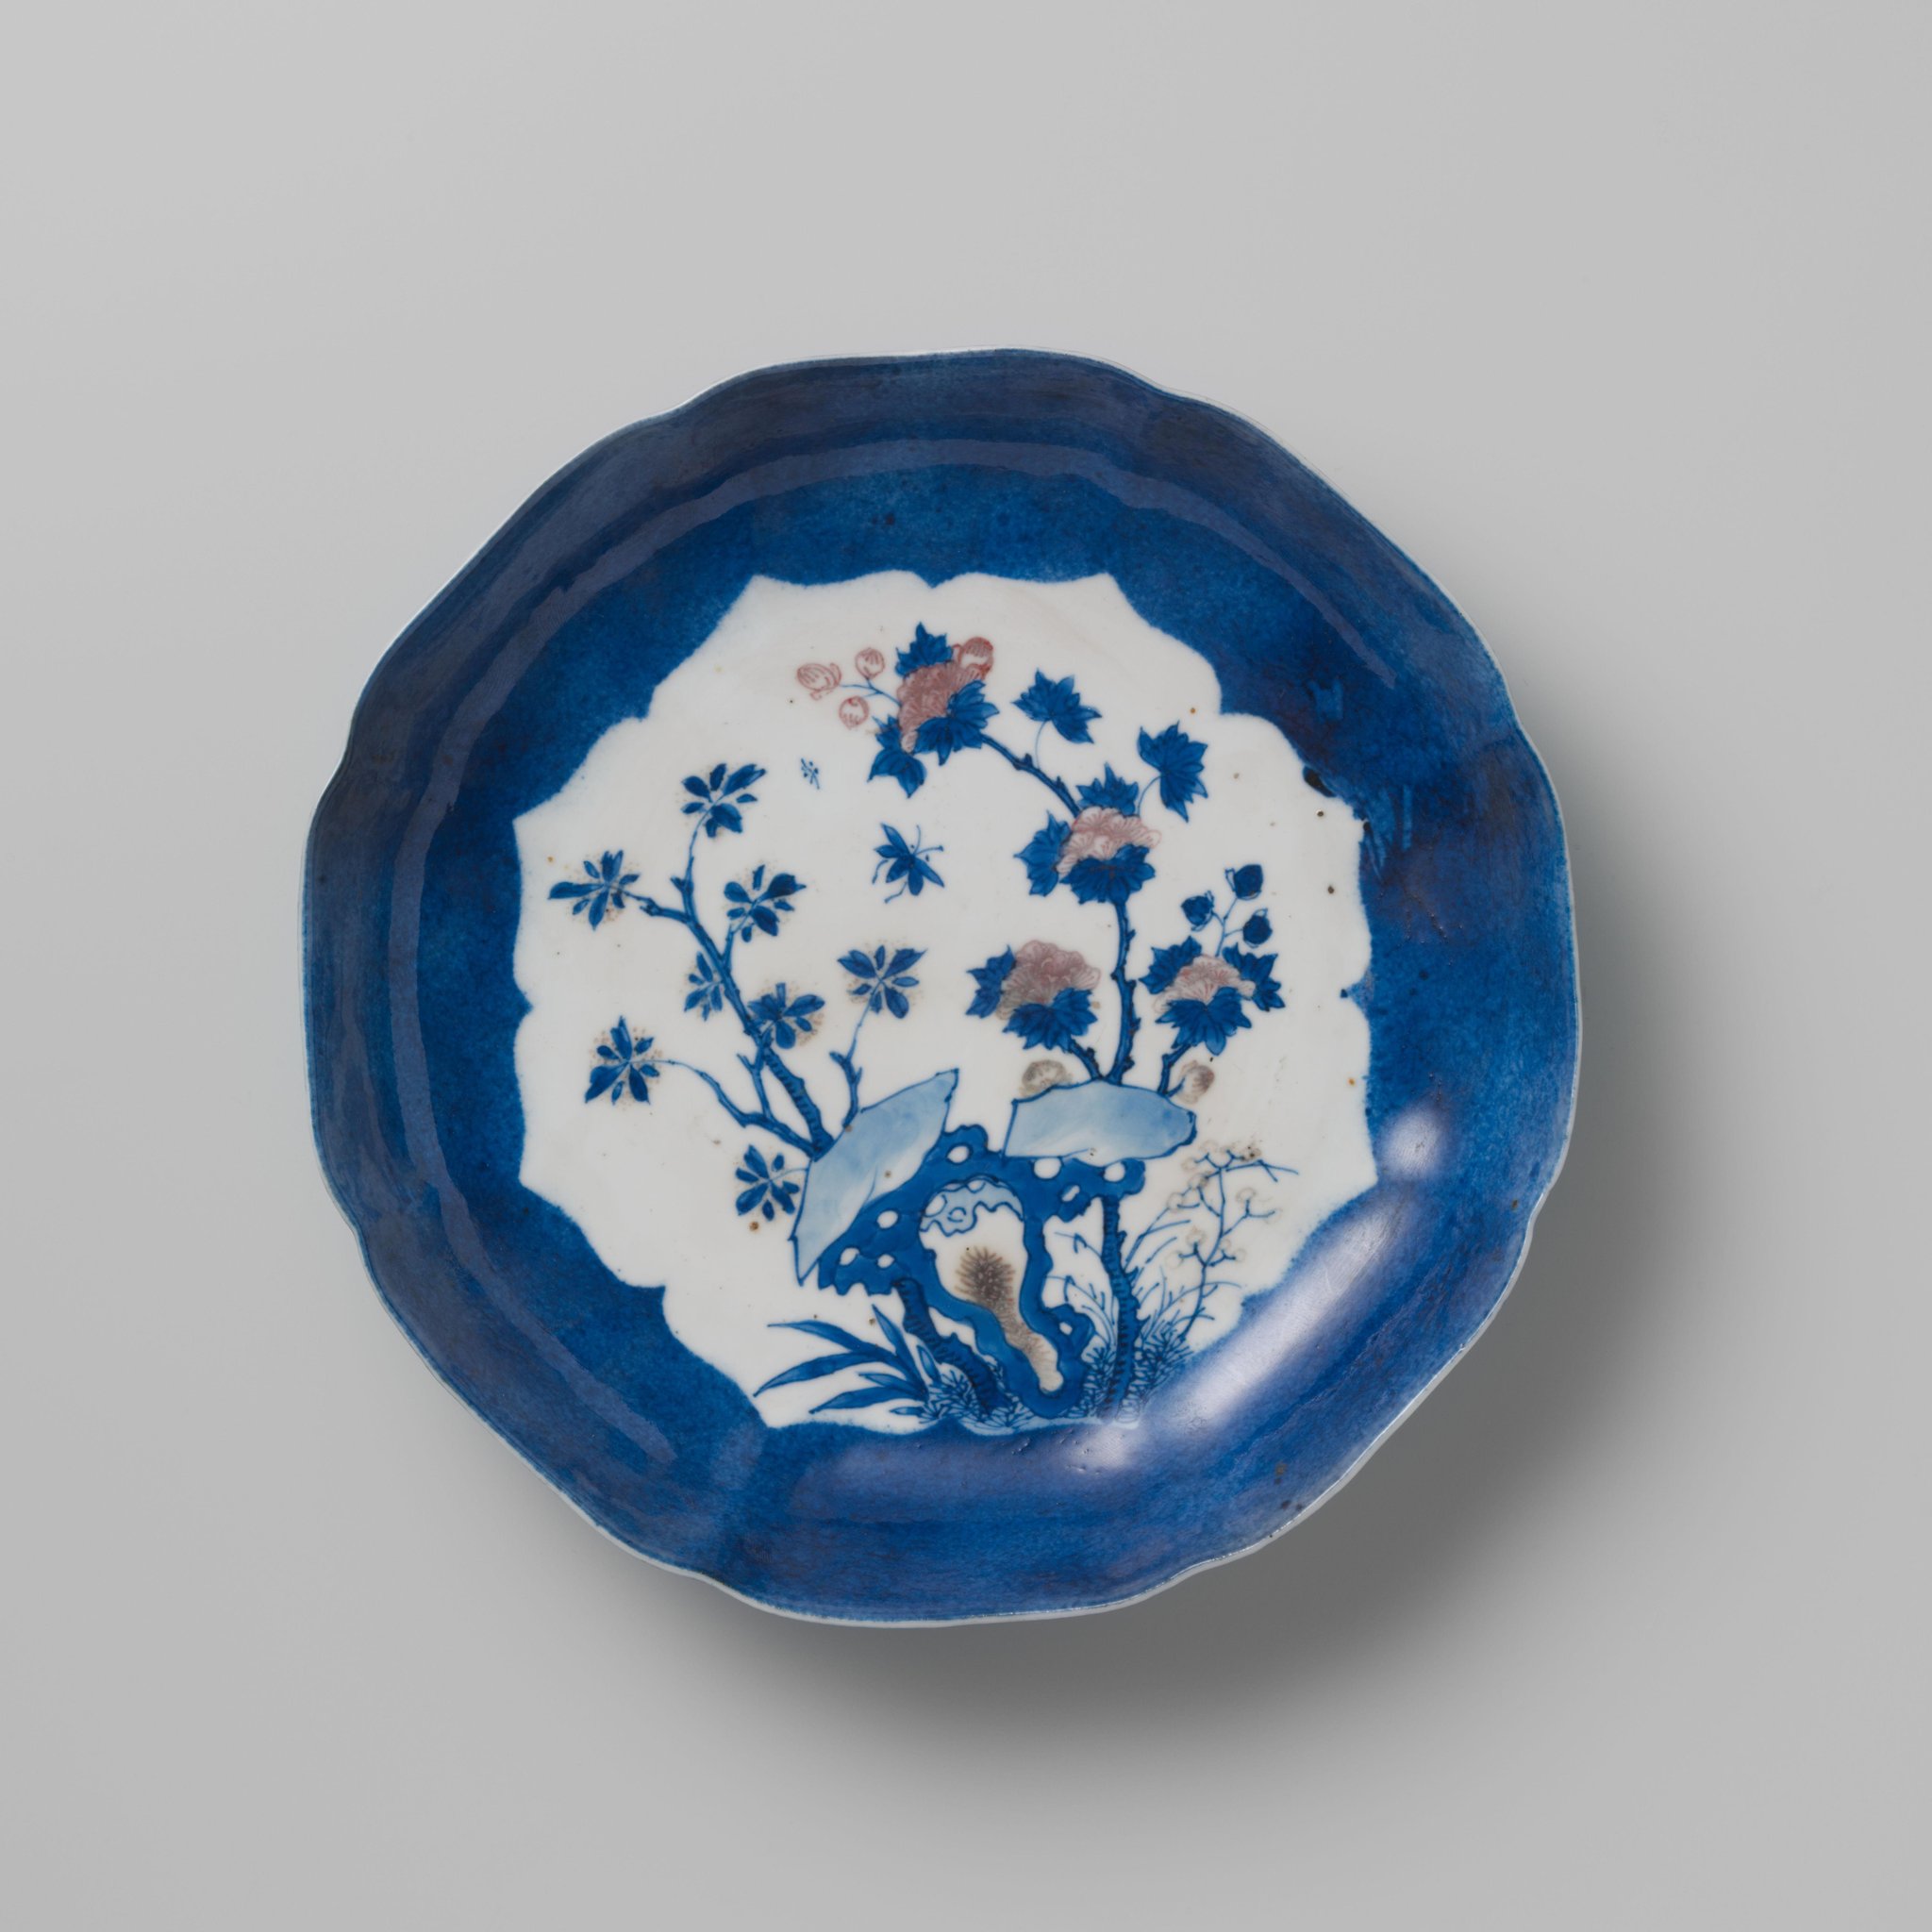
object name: platter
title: Saucer-dish with powder blue, rocks and flowering plants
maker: Anonymous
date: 1700-1724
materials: cobalt, copper, glaze, paint, porcelain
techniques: firing, turning, vitrification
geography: china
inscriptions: mark: ‘大 明 成 化 年 製 dà míng Chéng huà nián zhì’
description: Schotel van porselein met ronde, gelobde wand en accoladevormige rand, beschilderd in onderglazuur blauw en rood. De voorzijde is bedekt met bleu poudré (poederblauw) met op het plat een bloemvormige reserve met hierin rotsen en bloeiende planten; de achterzijde is ook bedekt met poederblauw met hierin viermaal een bloemtak gegrifd. Gemerkt op de onderzijde met het zes-karaktermerk van keizer Chenghua in een dubbele cirkel. Onderglazuur blauw met koperrood.